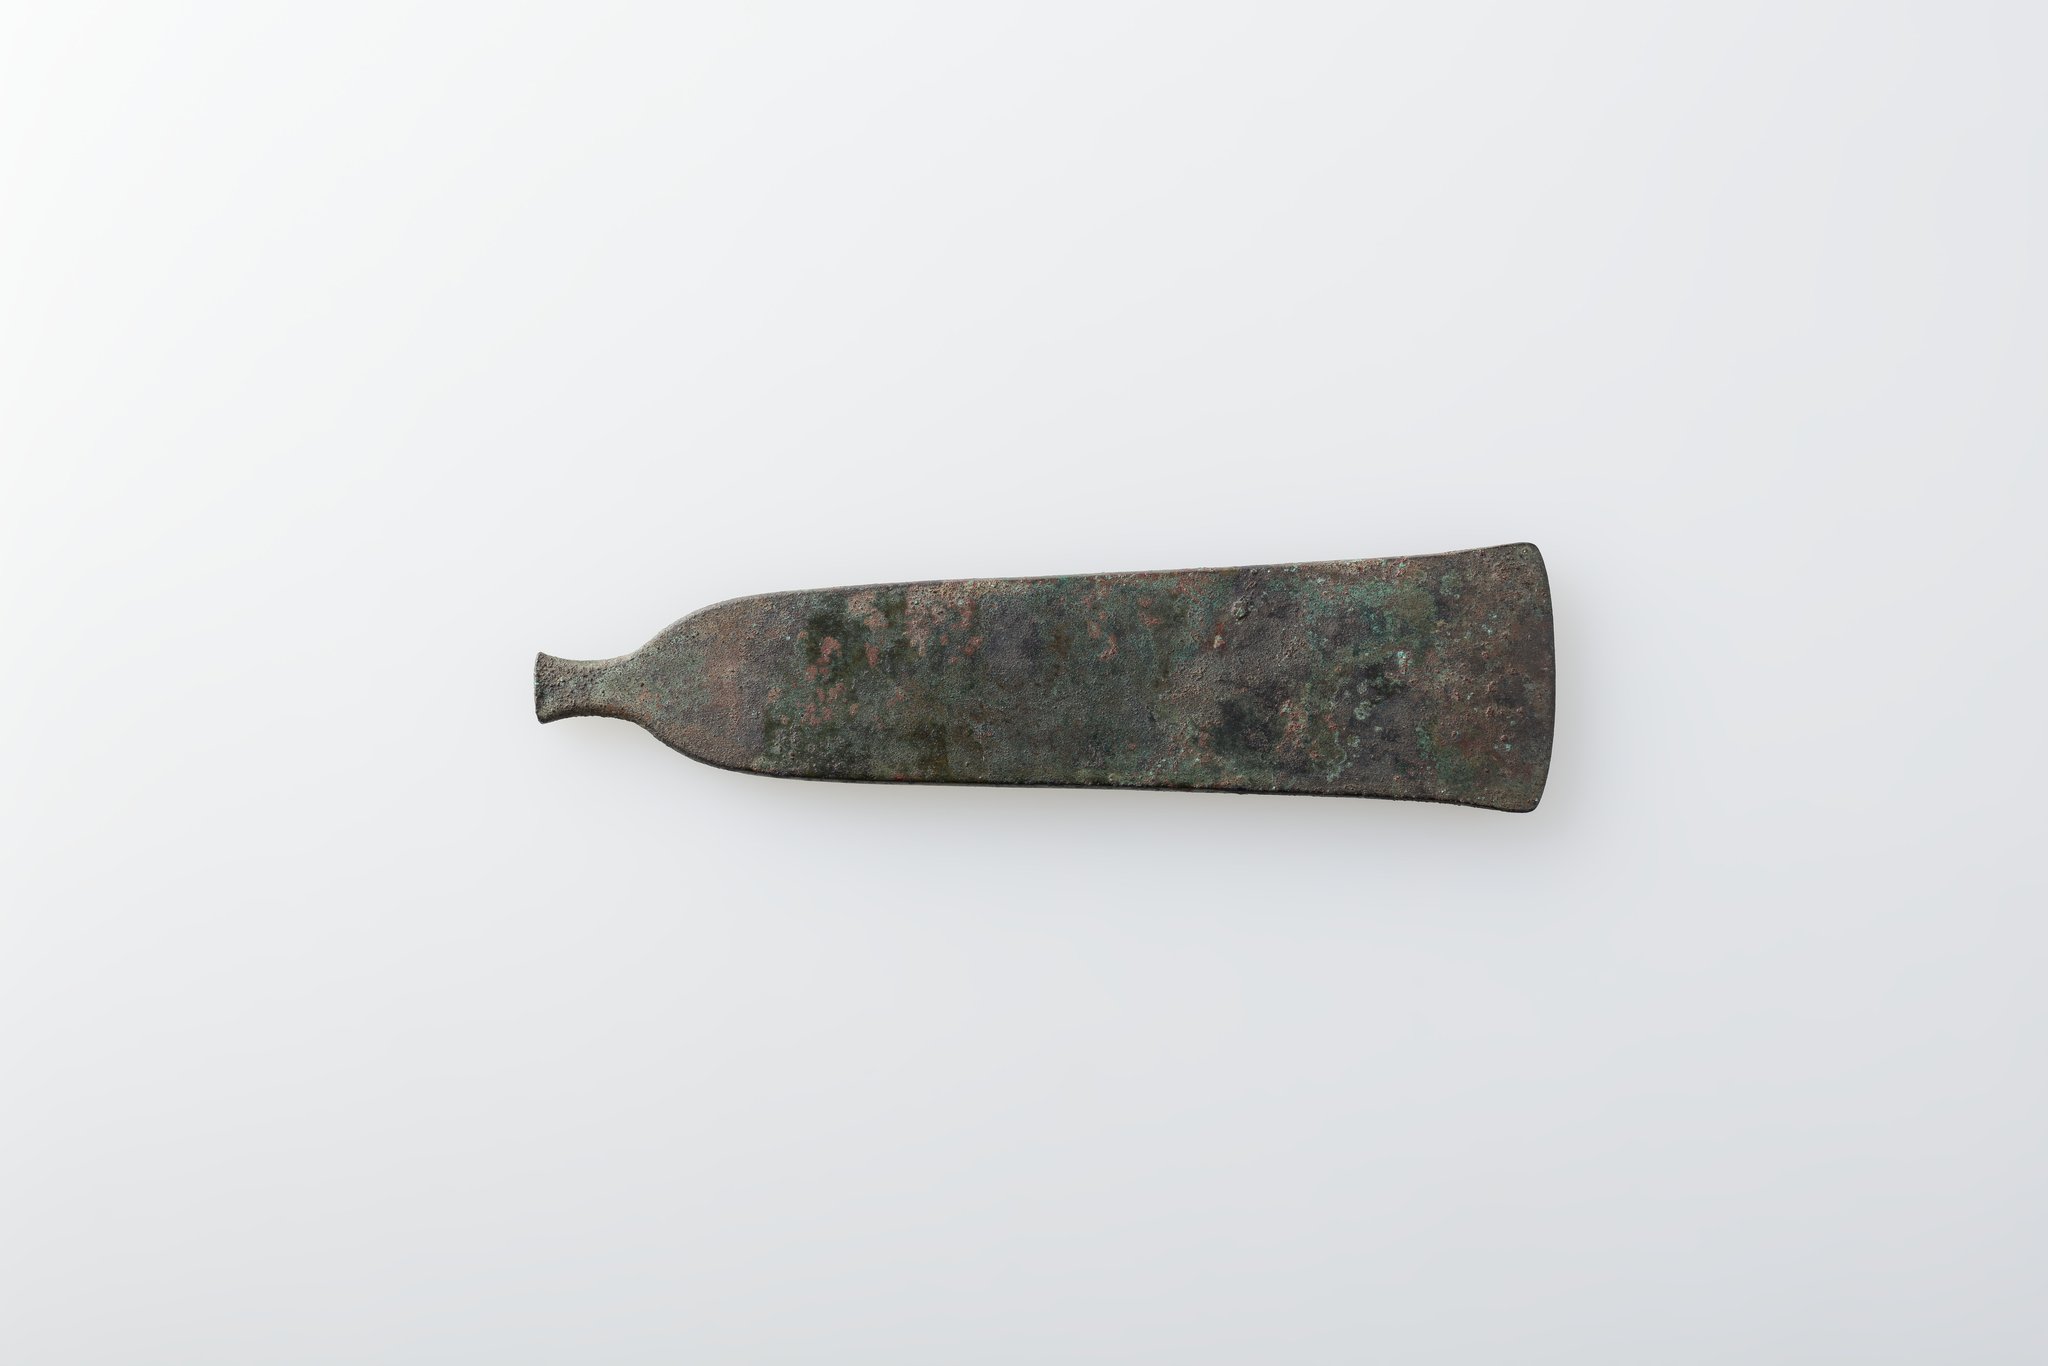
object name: adze blade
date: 1550-1458 BCE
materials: bronze, copper alloy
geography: egypt